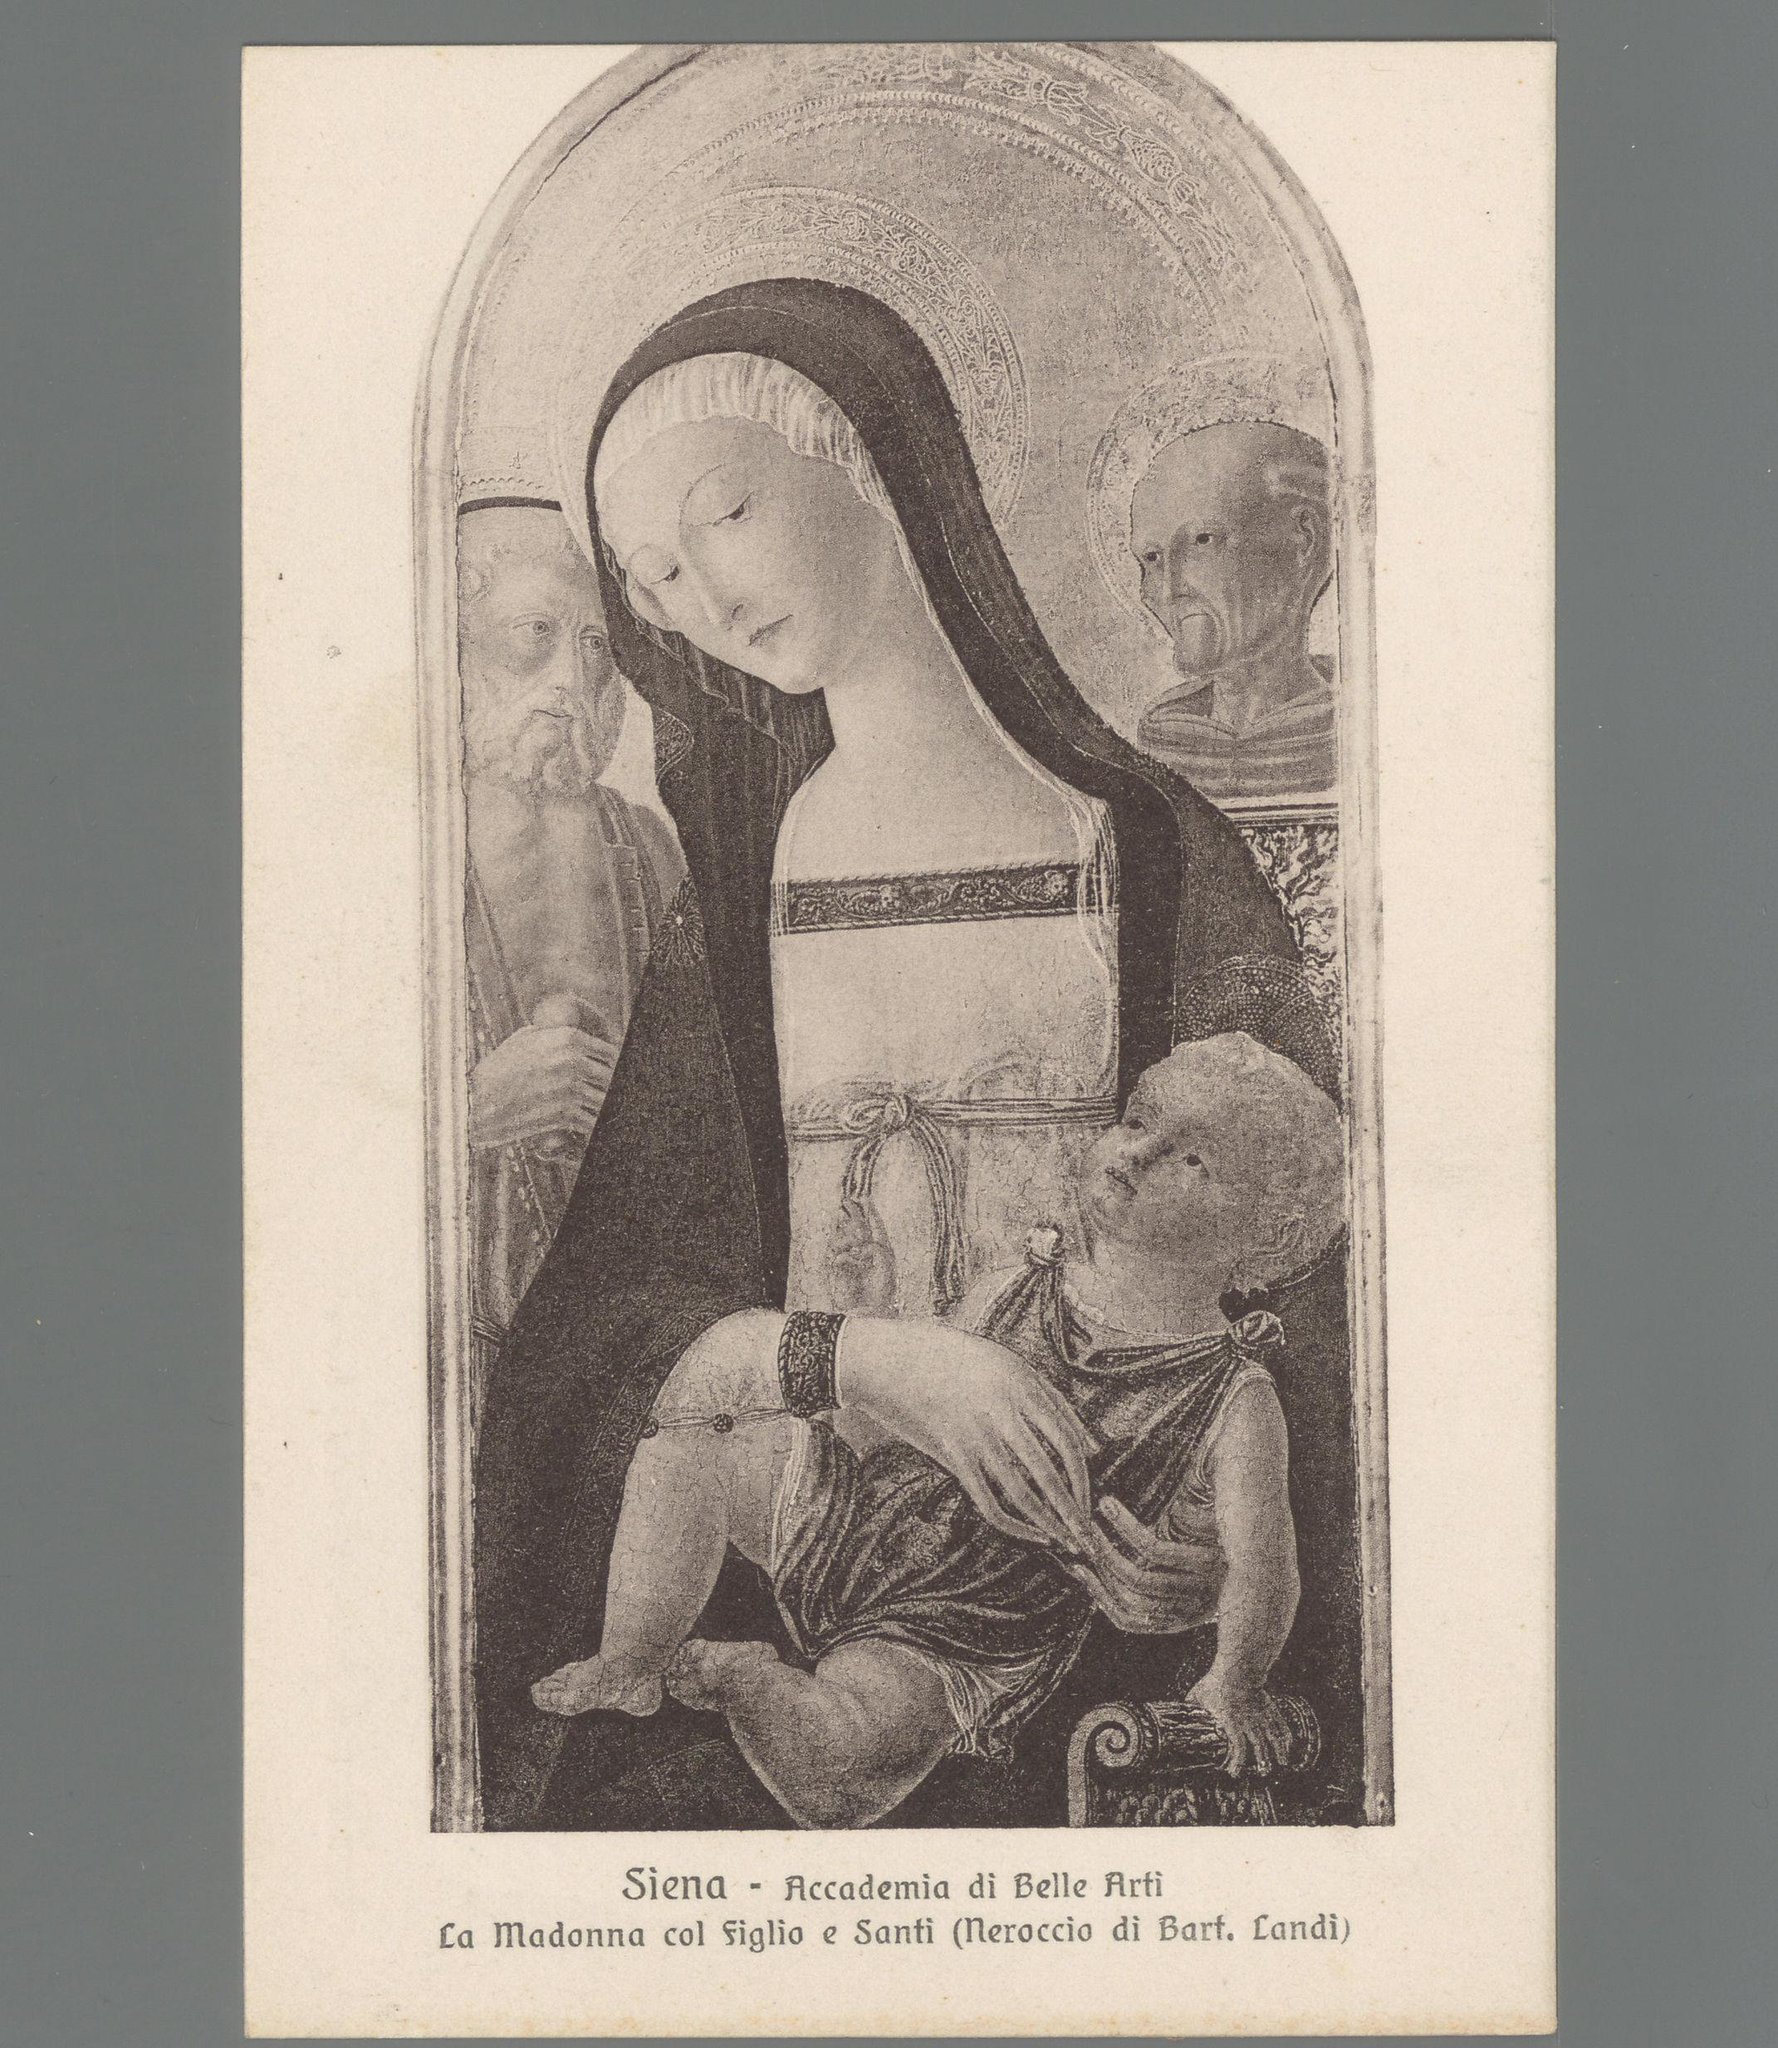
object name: photomechanical print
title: Siena - Accademia di Belle Arti. La Madonna col figlio e Santi (Neroccio di Bart. Landi)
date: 1906-1930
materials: cardboard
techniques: photograph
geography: siena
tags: permanent exhibition, museum, picture, painting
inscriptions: collector's mark: ‘AFE v S’